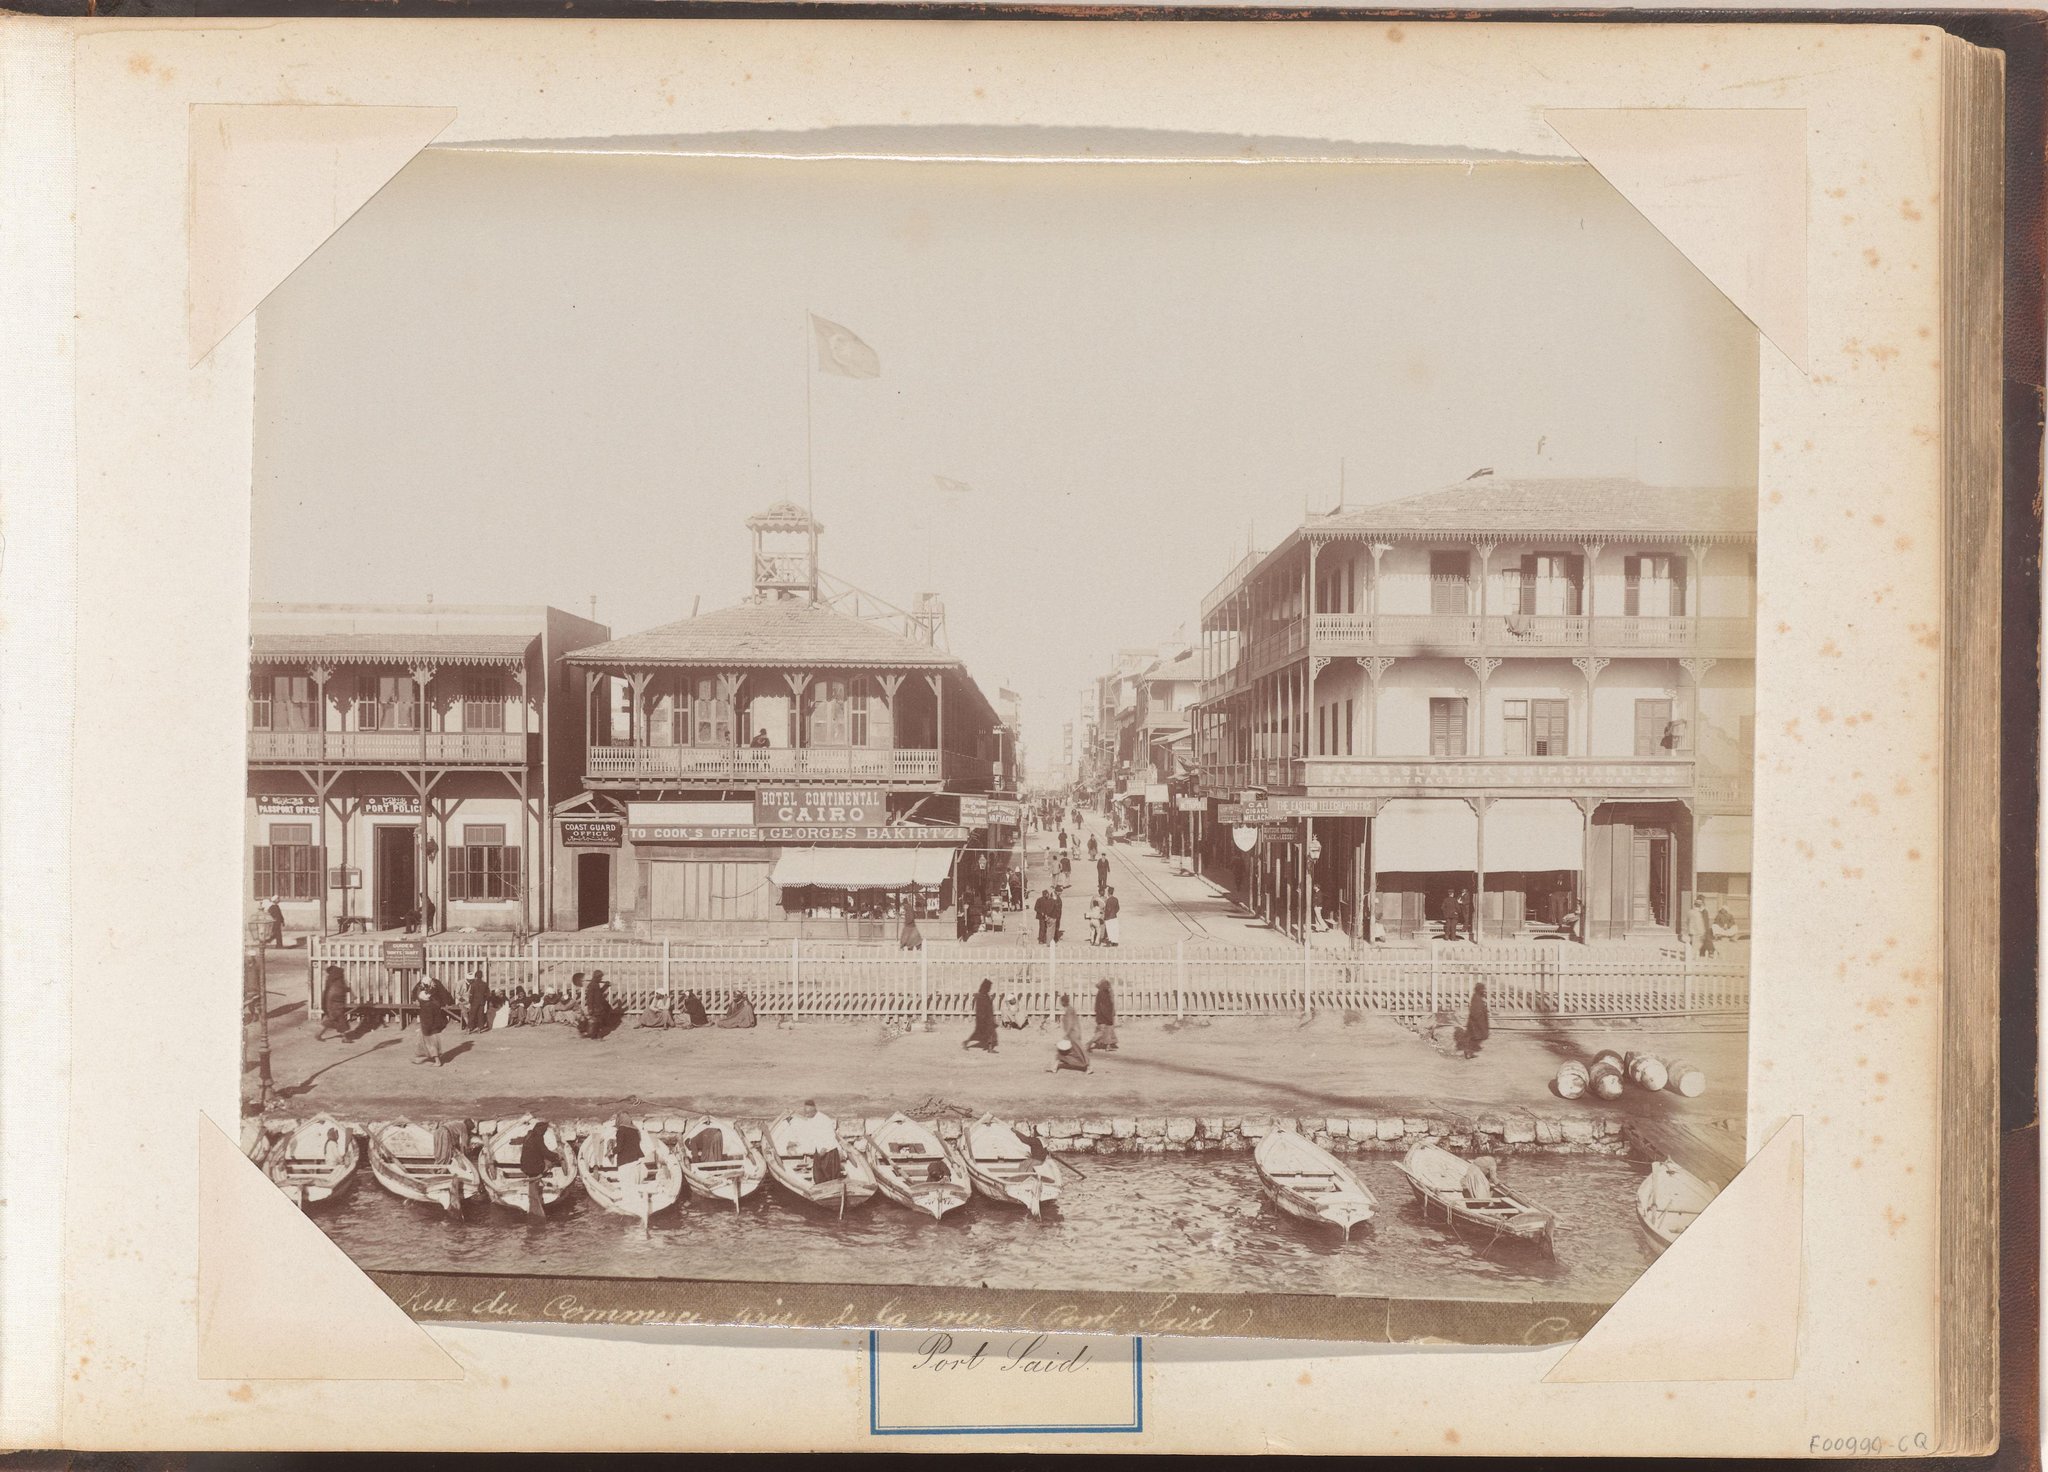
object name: photograph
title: Port Said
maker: peridis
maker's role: fotograaf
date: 1870-1890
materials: paper, photographic support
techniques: albumen print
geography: port said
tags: street (+ city(-scape) with figures, staffage)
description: Onderdeel van Album met 191 foto's van een reis naar en door Zuid-Afrika.